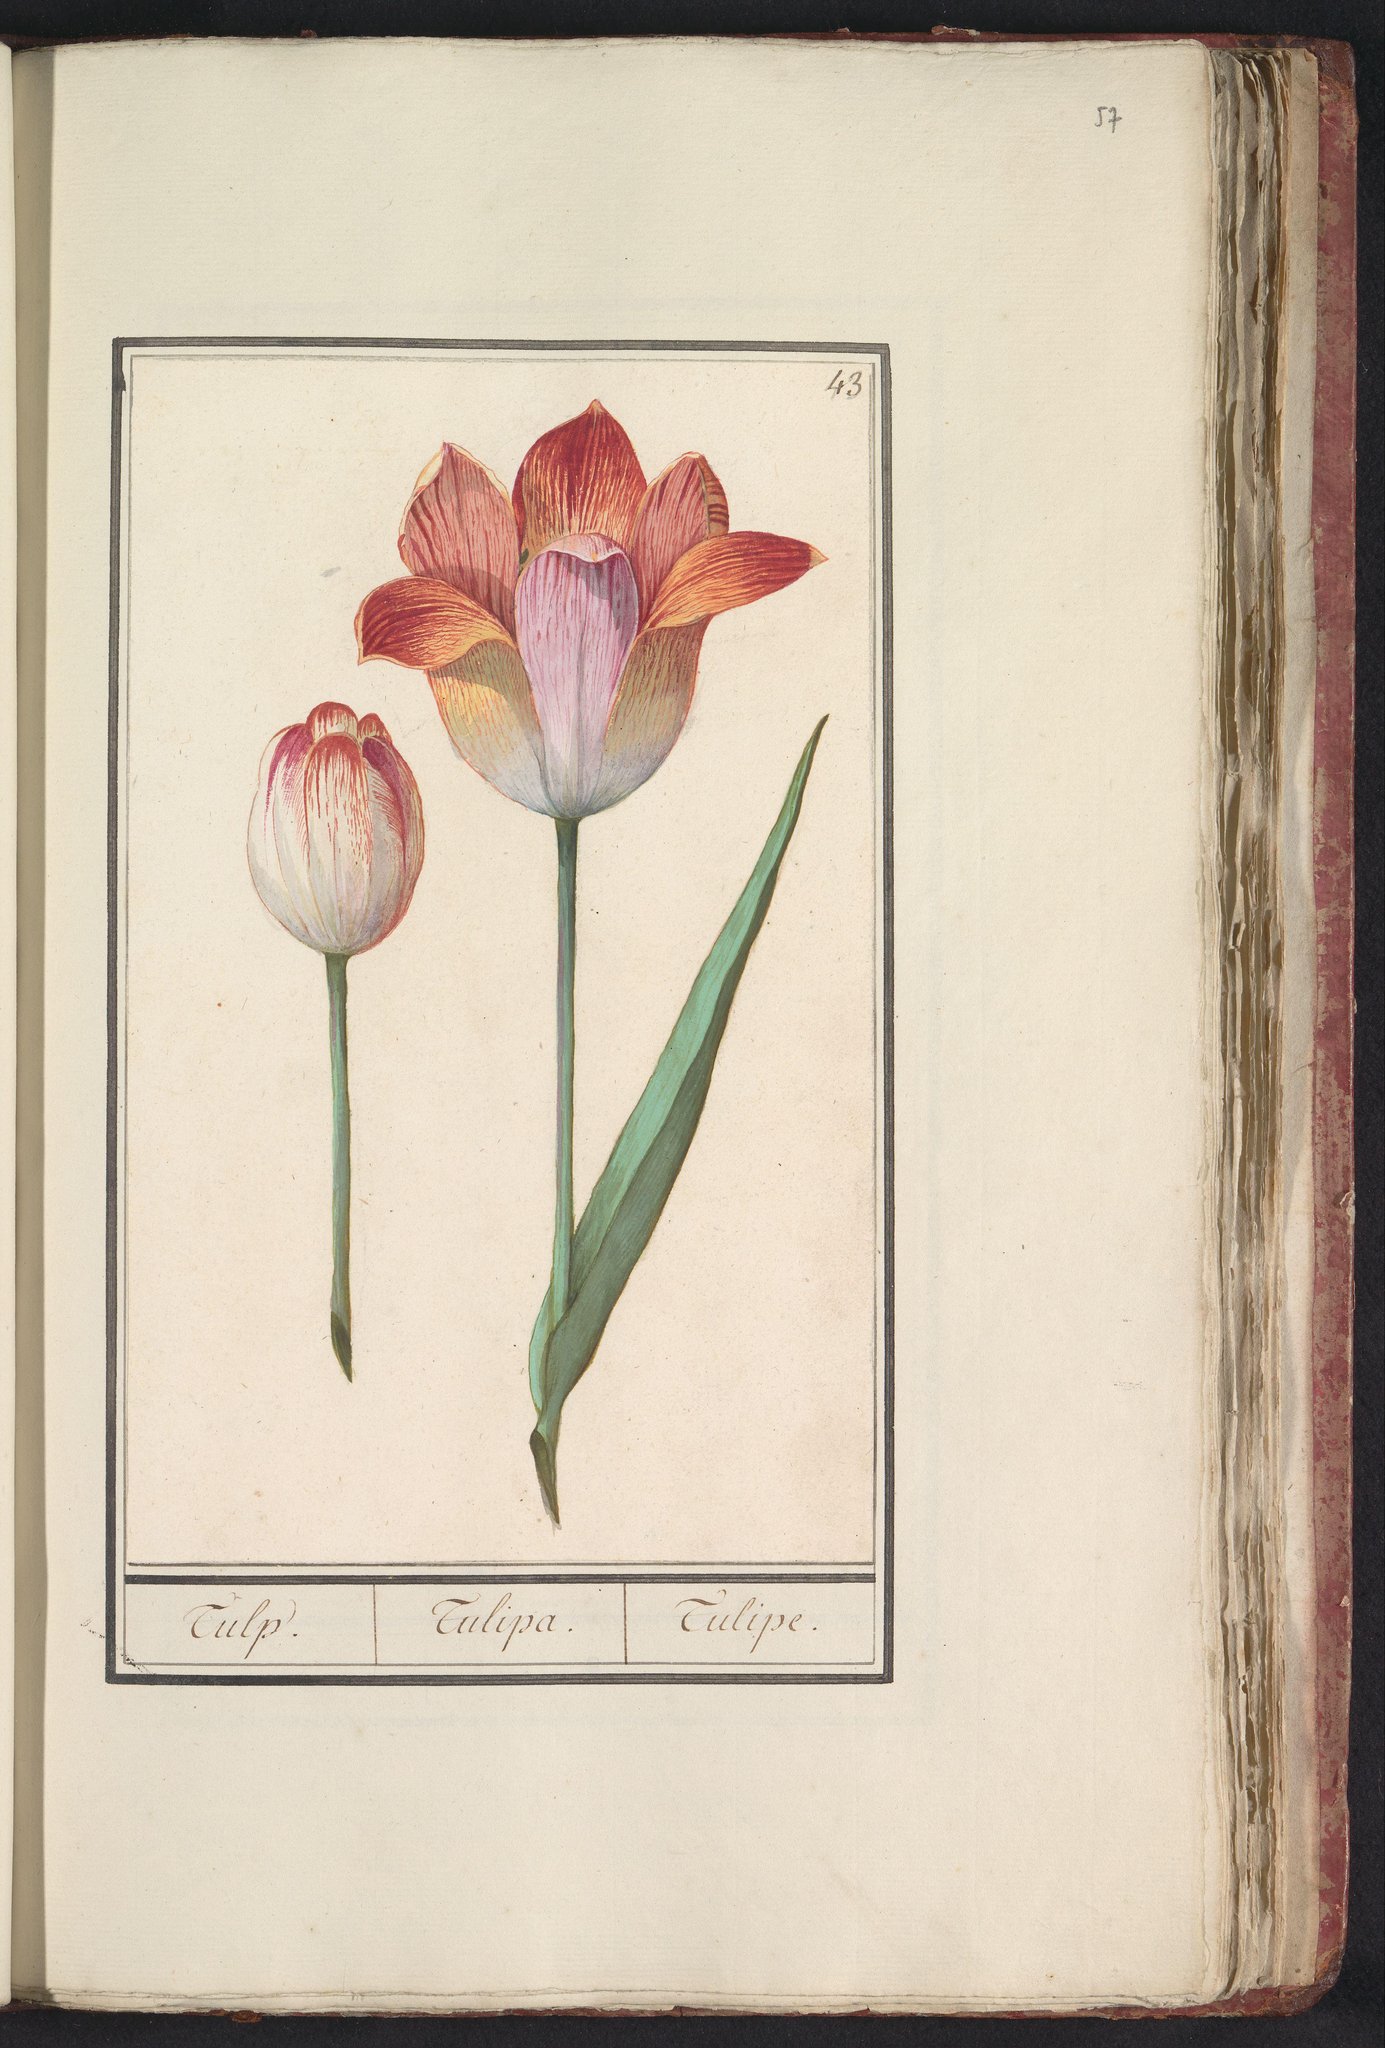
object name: drawing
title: Tulp. / Tulipa. / Tulipe.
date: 1596-1610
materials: chalk, paint, paper, watercolor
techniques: brush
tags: flowers: tulip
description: Wit-rode en rood-geel-roze tulp. Genummerd rechtsboven: 43. Onderdeel van het eerste album met tekeningen van bloemen en planten. Achtste van twaalf albums met tekeningen van dieren, vogels en planten bekend rond 1600, gemaakt in opdracht van keizer Rudolf II. Met toelichting in Nederlands, Latijn en Frans.